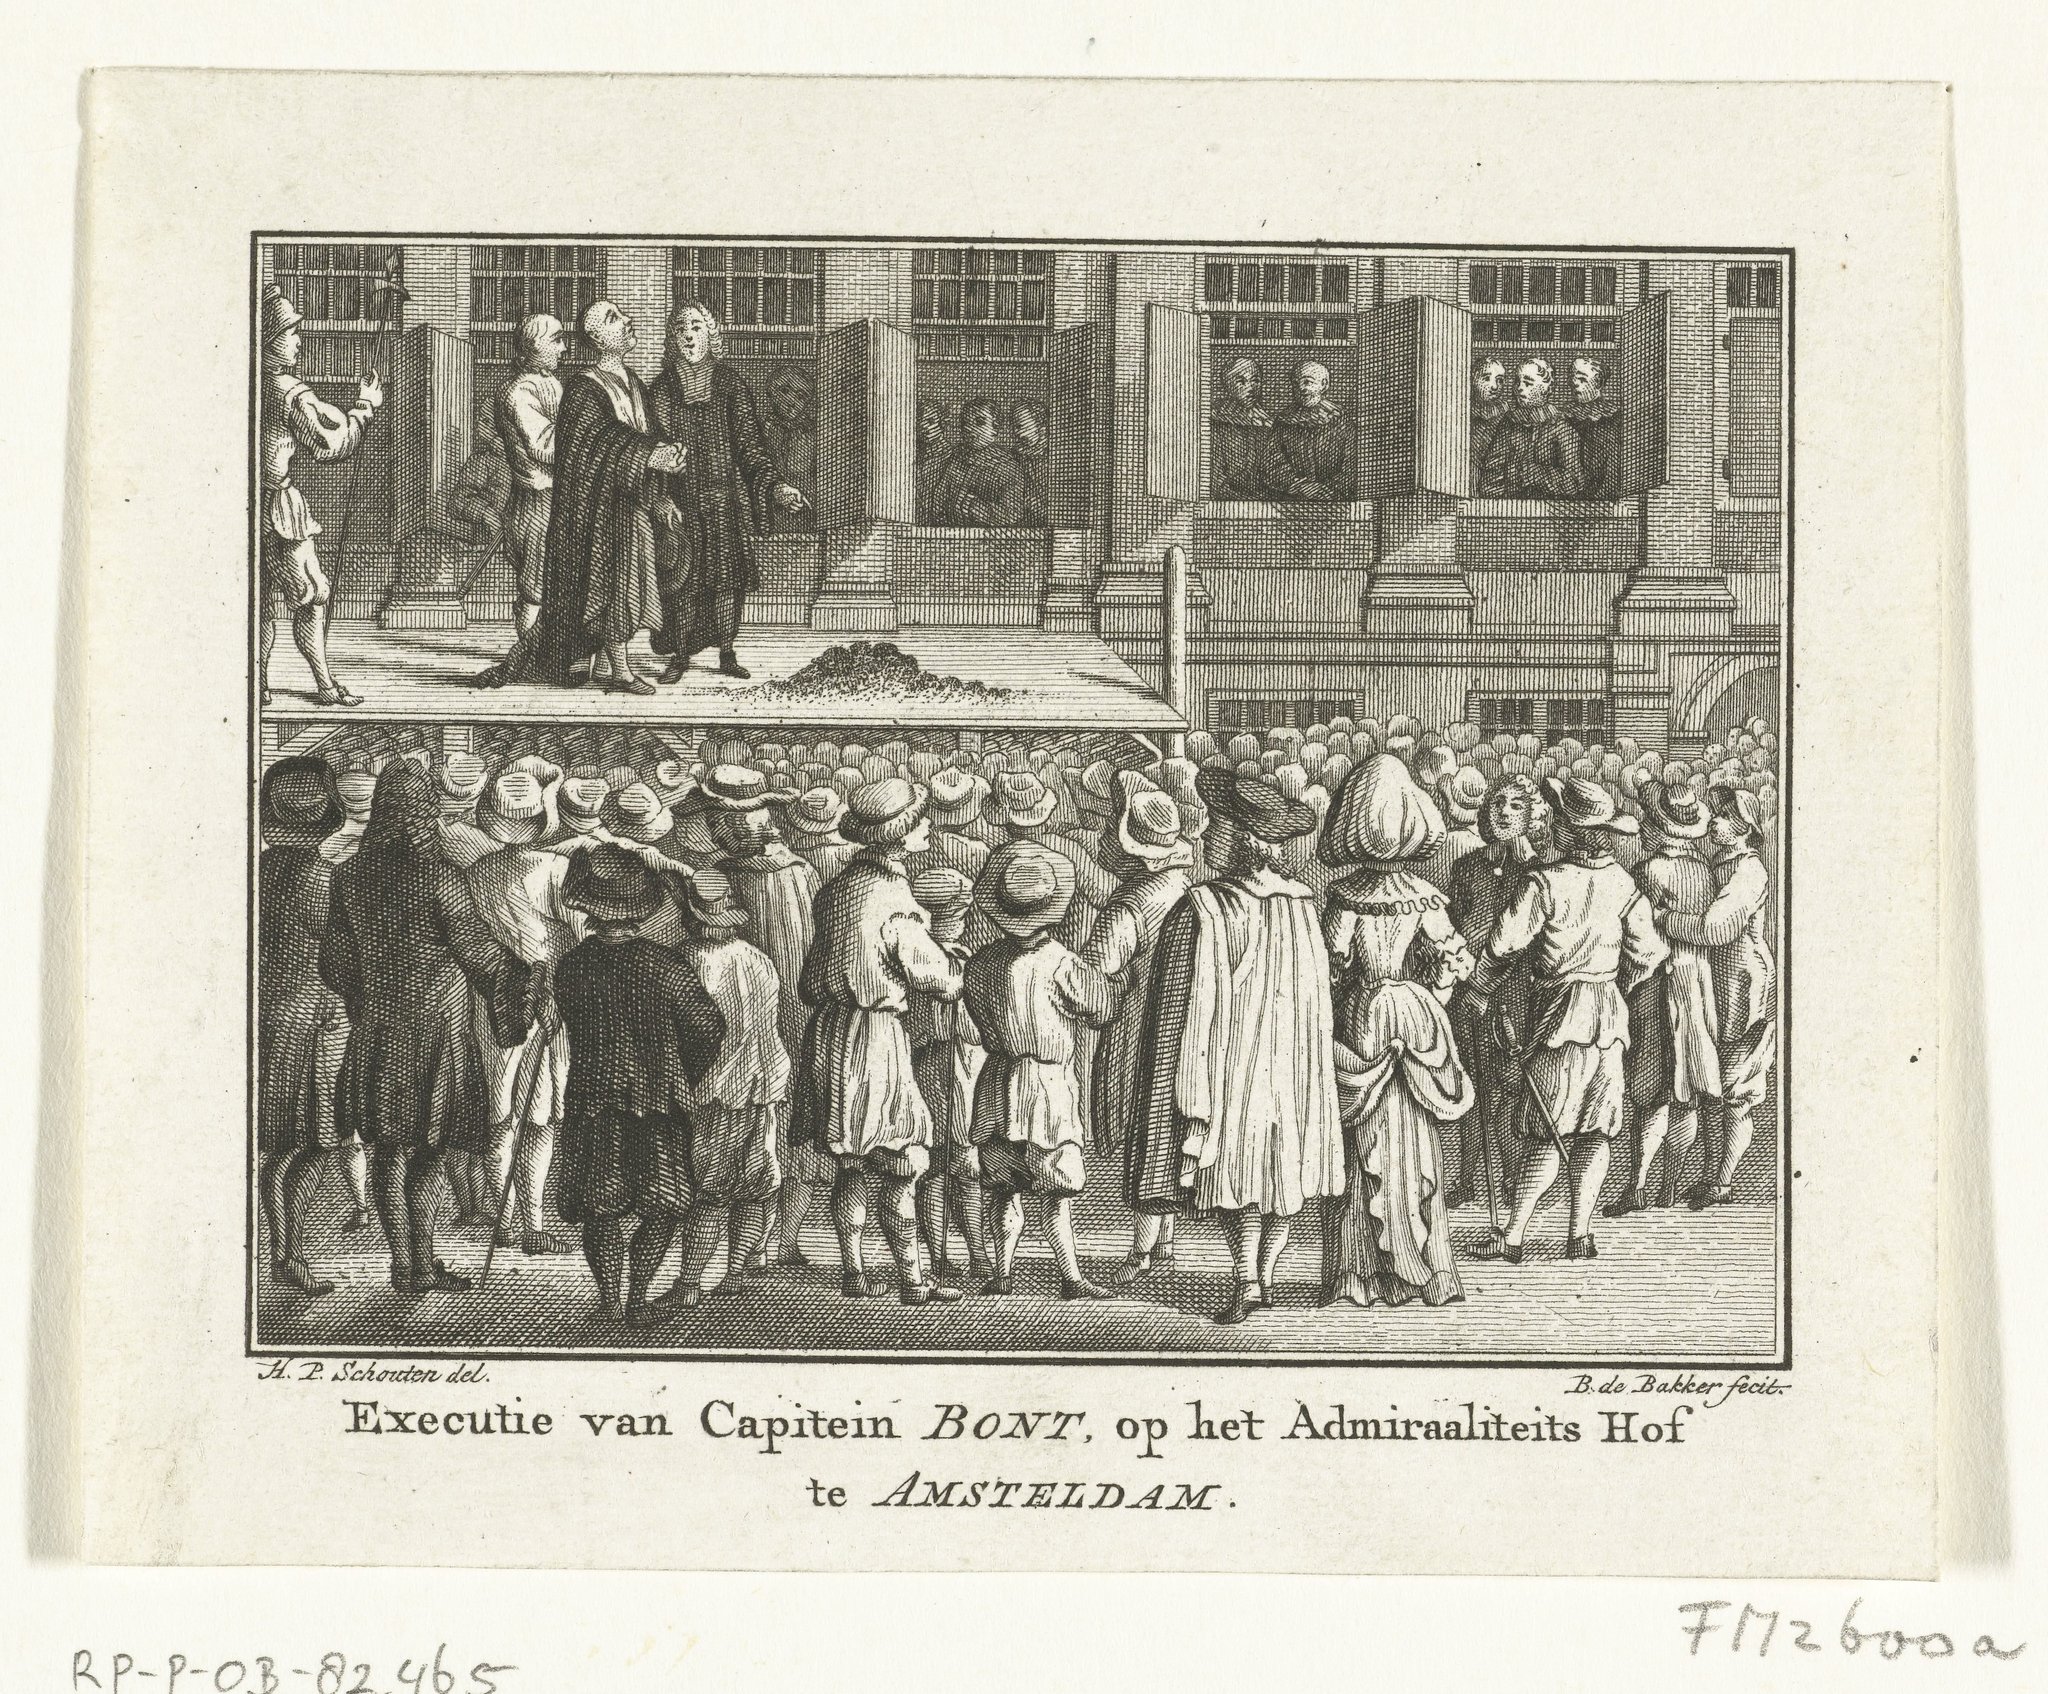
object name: history print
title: Executie van kapitein Bont, 1677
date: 1780-1782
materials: paper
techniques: etching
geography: northern netherlands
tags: on the scaffold or place of execution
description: Executie van kapitein Jan Bont op 5 februari op het Admiraliteits- of Prinsenhof aan de Oudezijds Voorburgwal te Amsterdam. Veroordeeld wegens ongeoorloofd verlaten van de vloot van Jacob Binckes in West-Indië. Bont staande op het schavot voor zijn onthoofding.